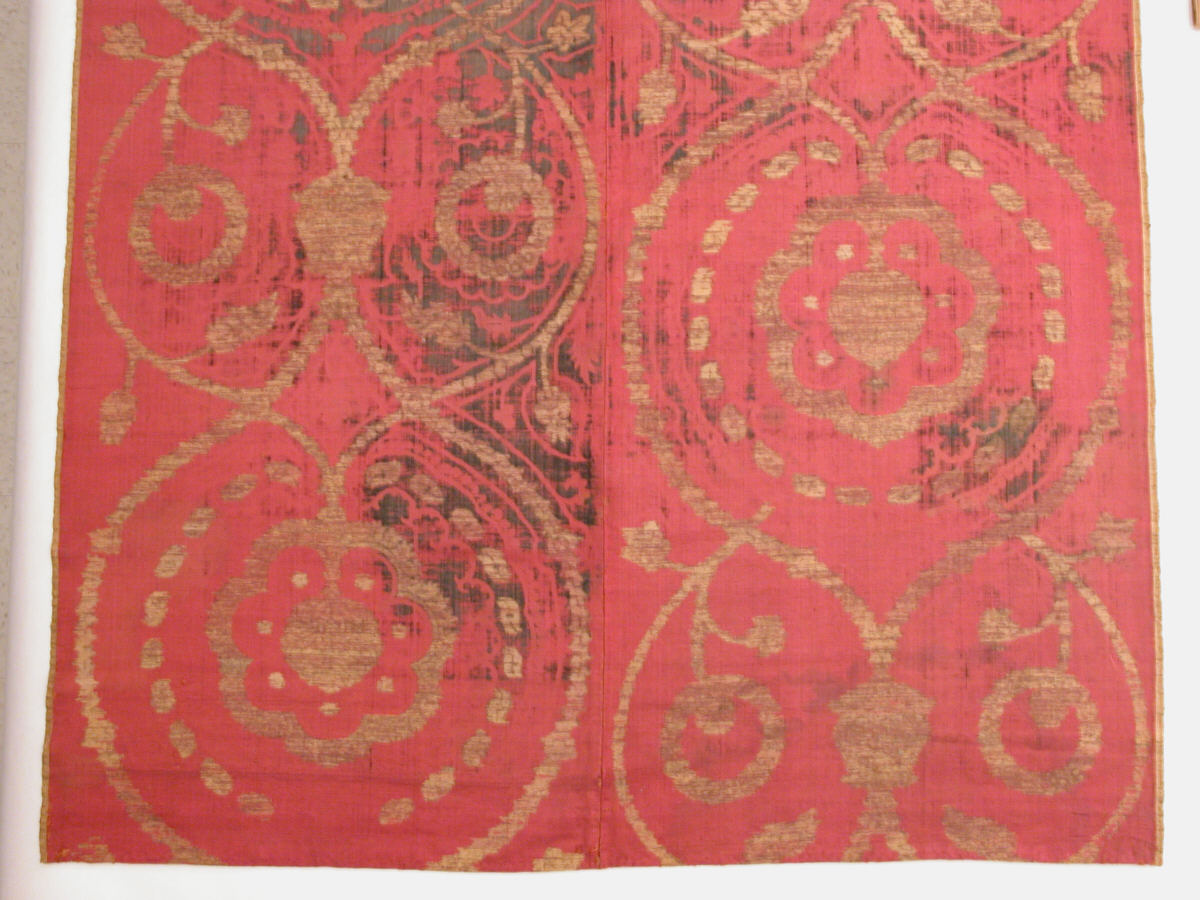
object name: fragment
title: Textile Fragment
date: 1501-1600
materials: metal thread, silk, velvet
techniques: brocade, cutting, voiding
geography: turkey